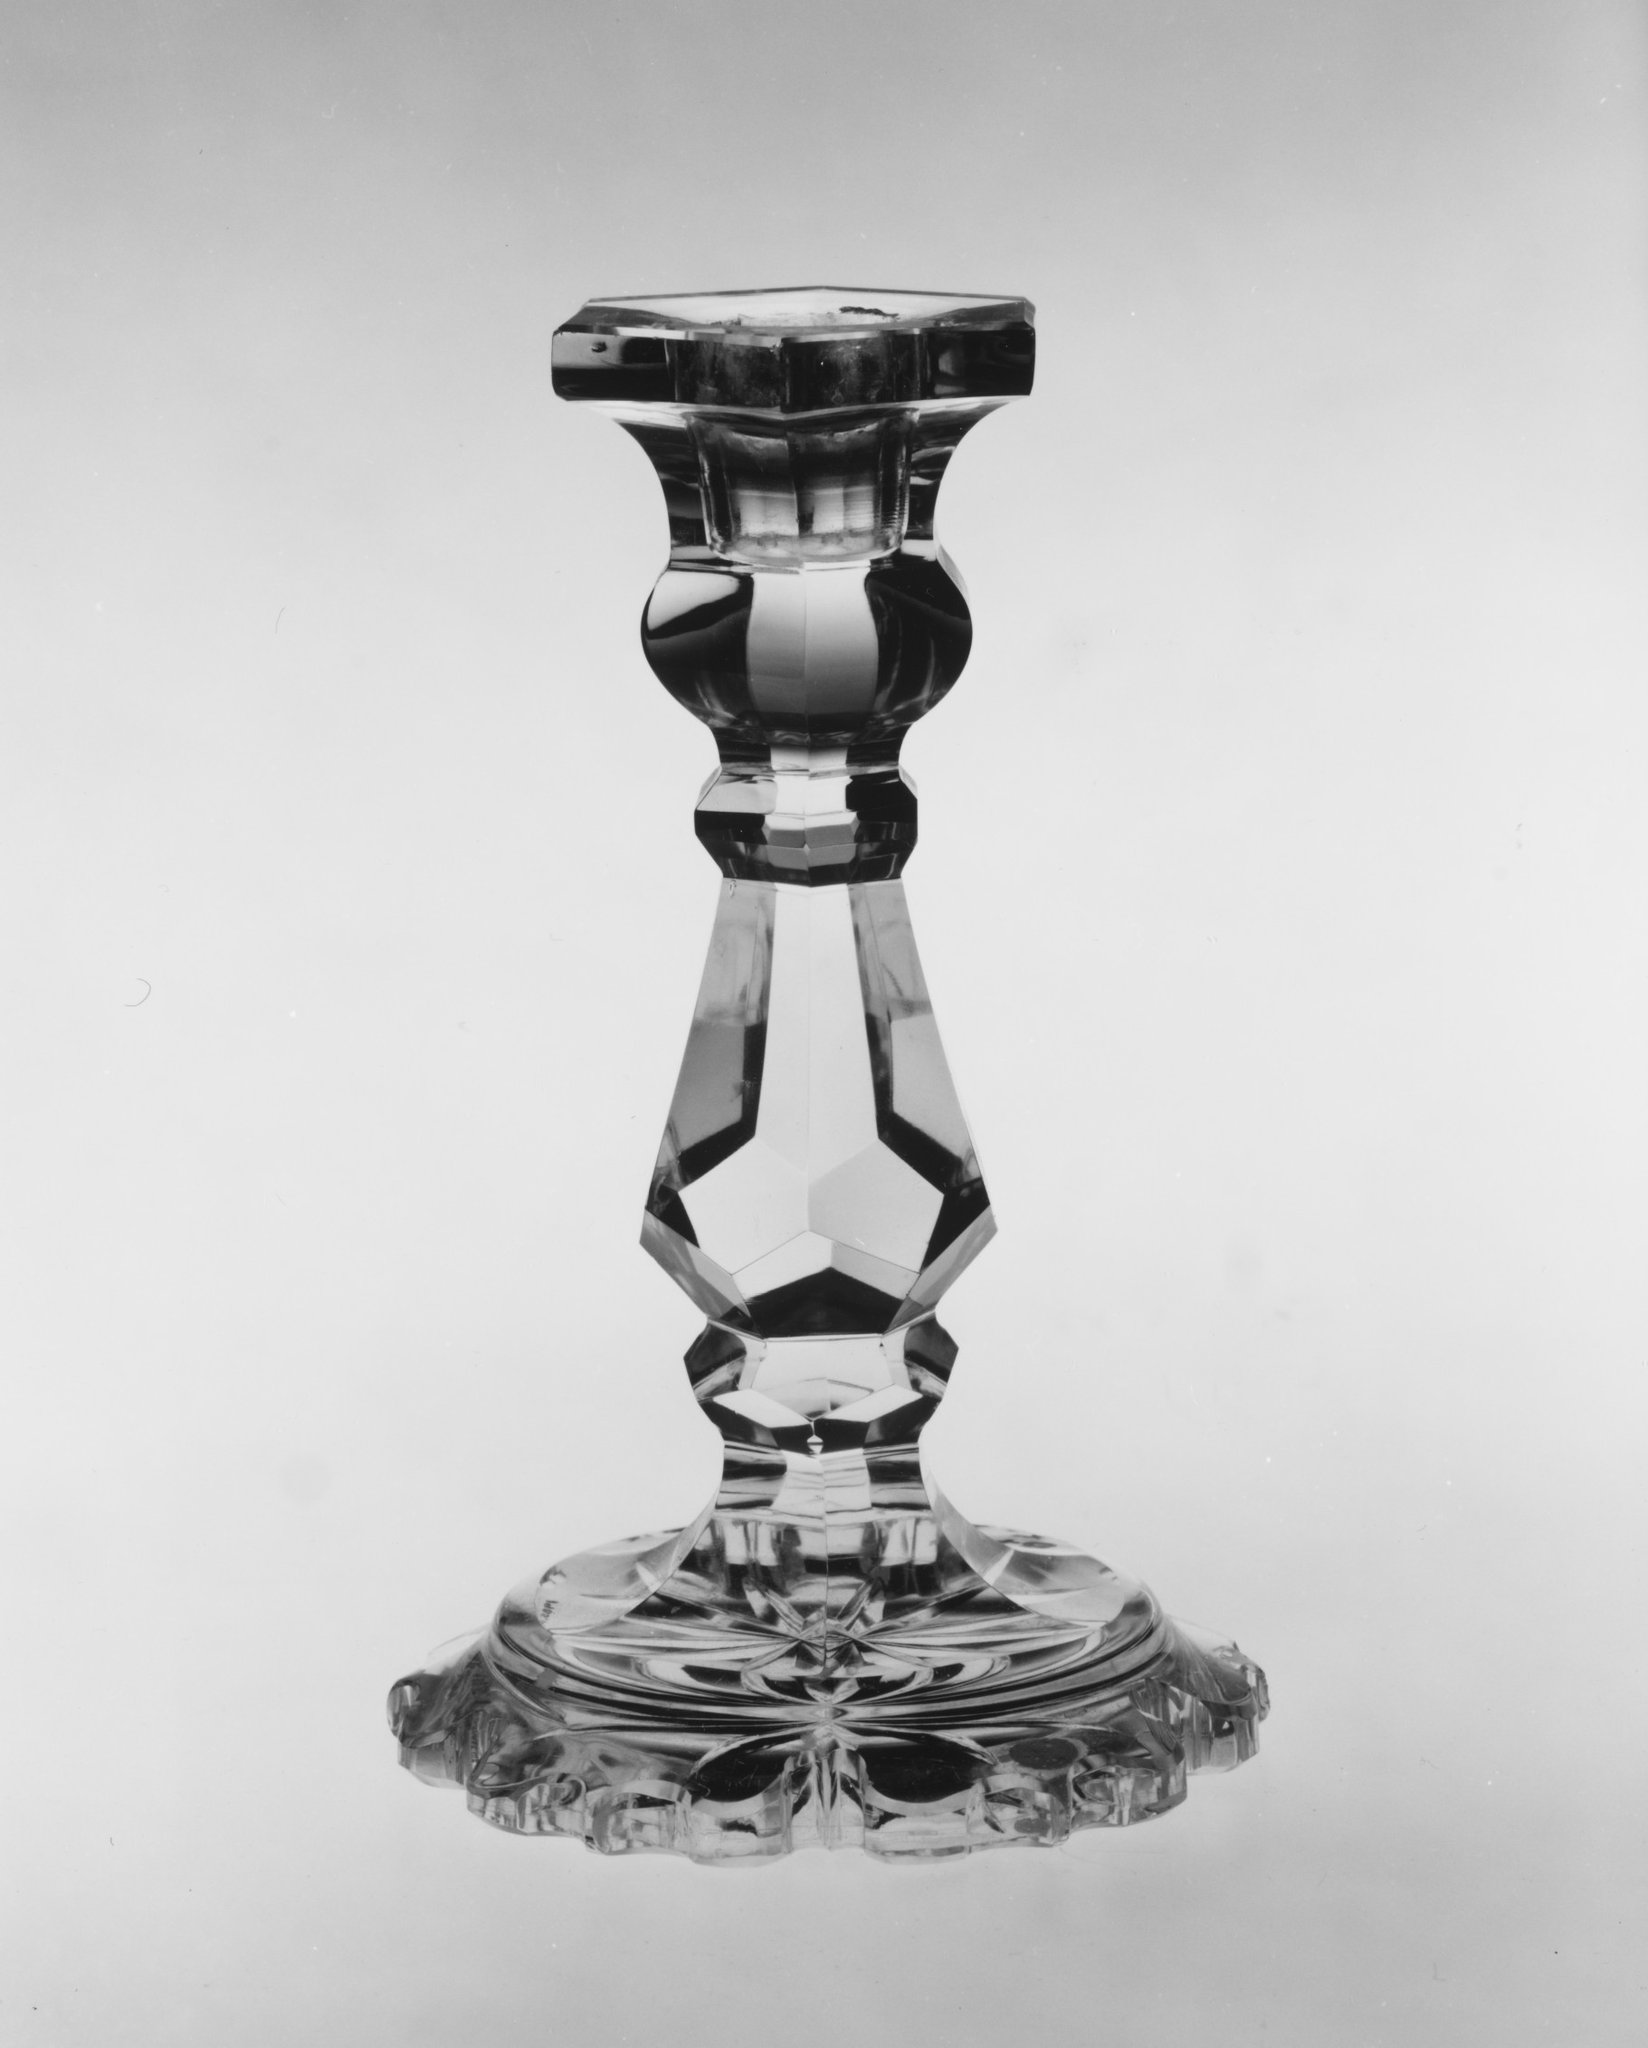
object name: candlestick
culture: american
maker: christian dorflinger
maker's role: maker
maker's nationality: french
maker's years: 1828-1915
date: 1852-1860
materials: glass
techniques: glassblowing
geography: united states